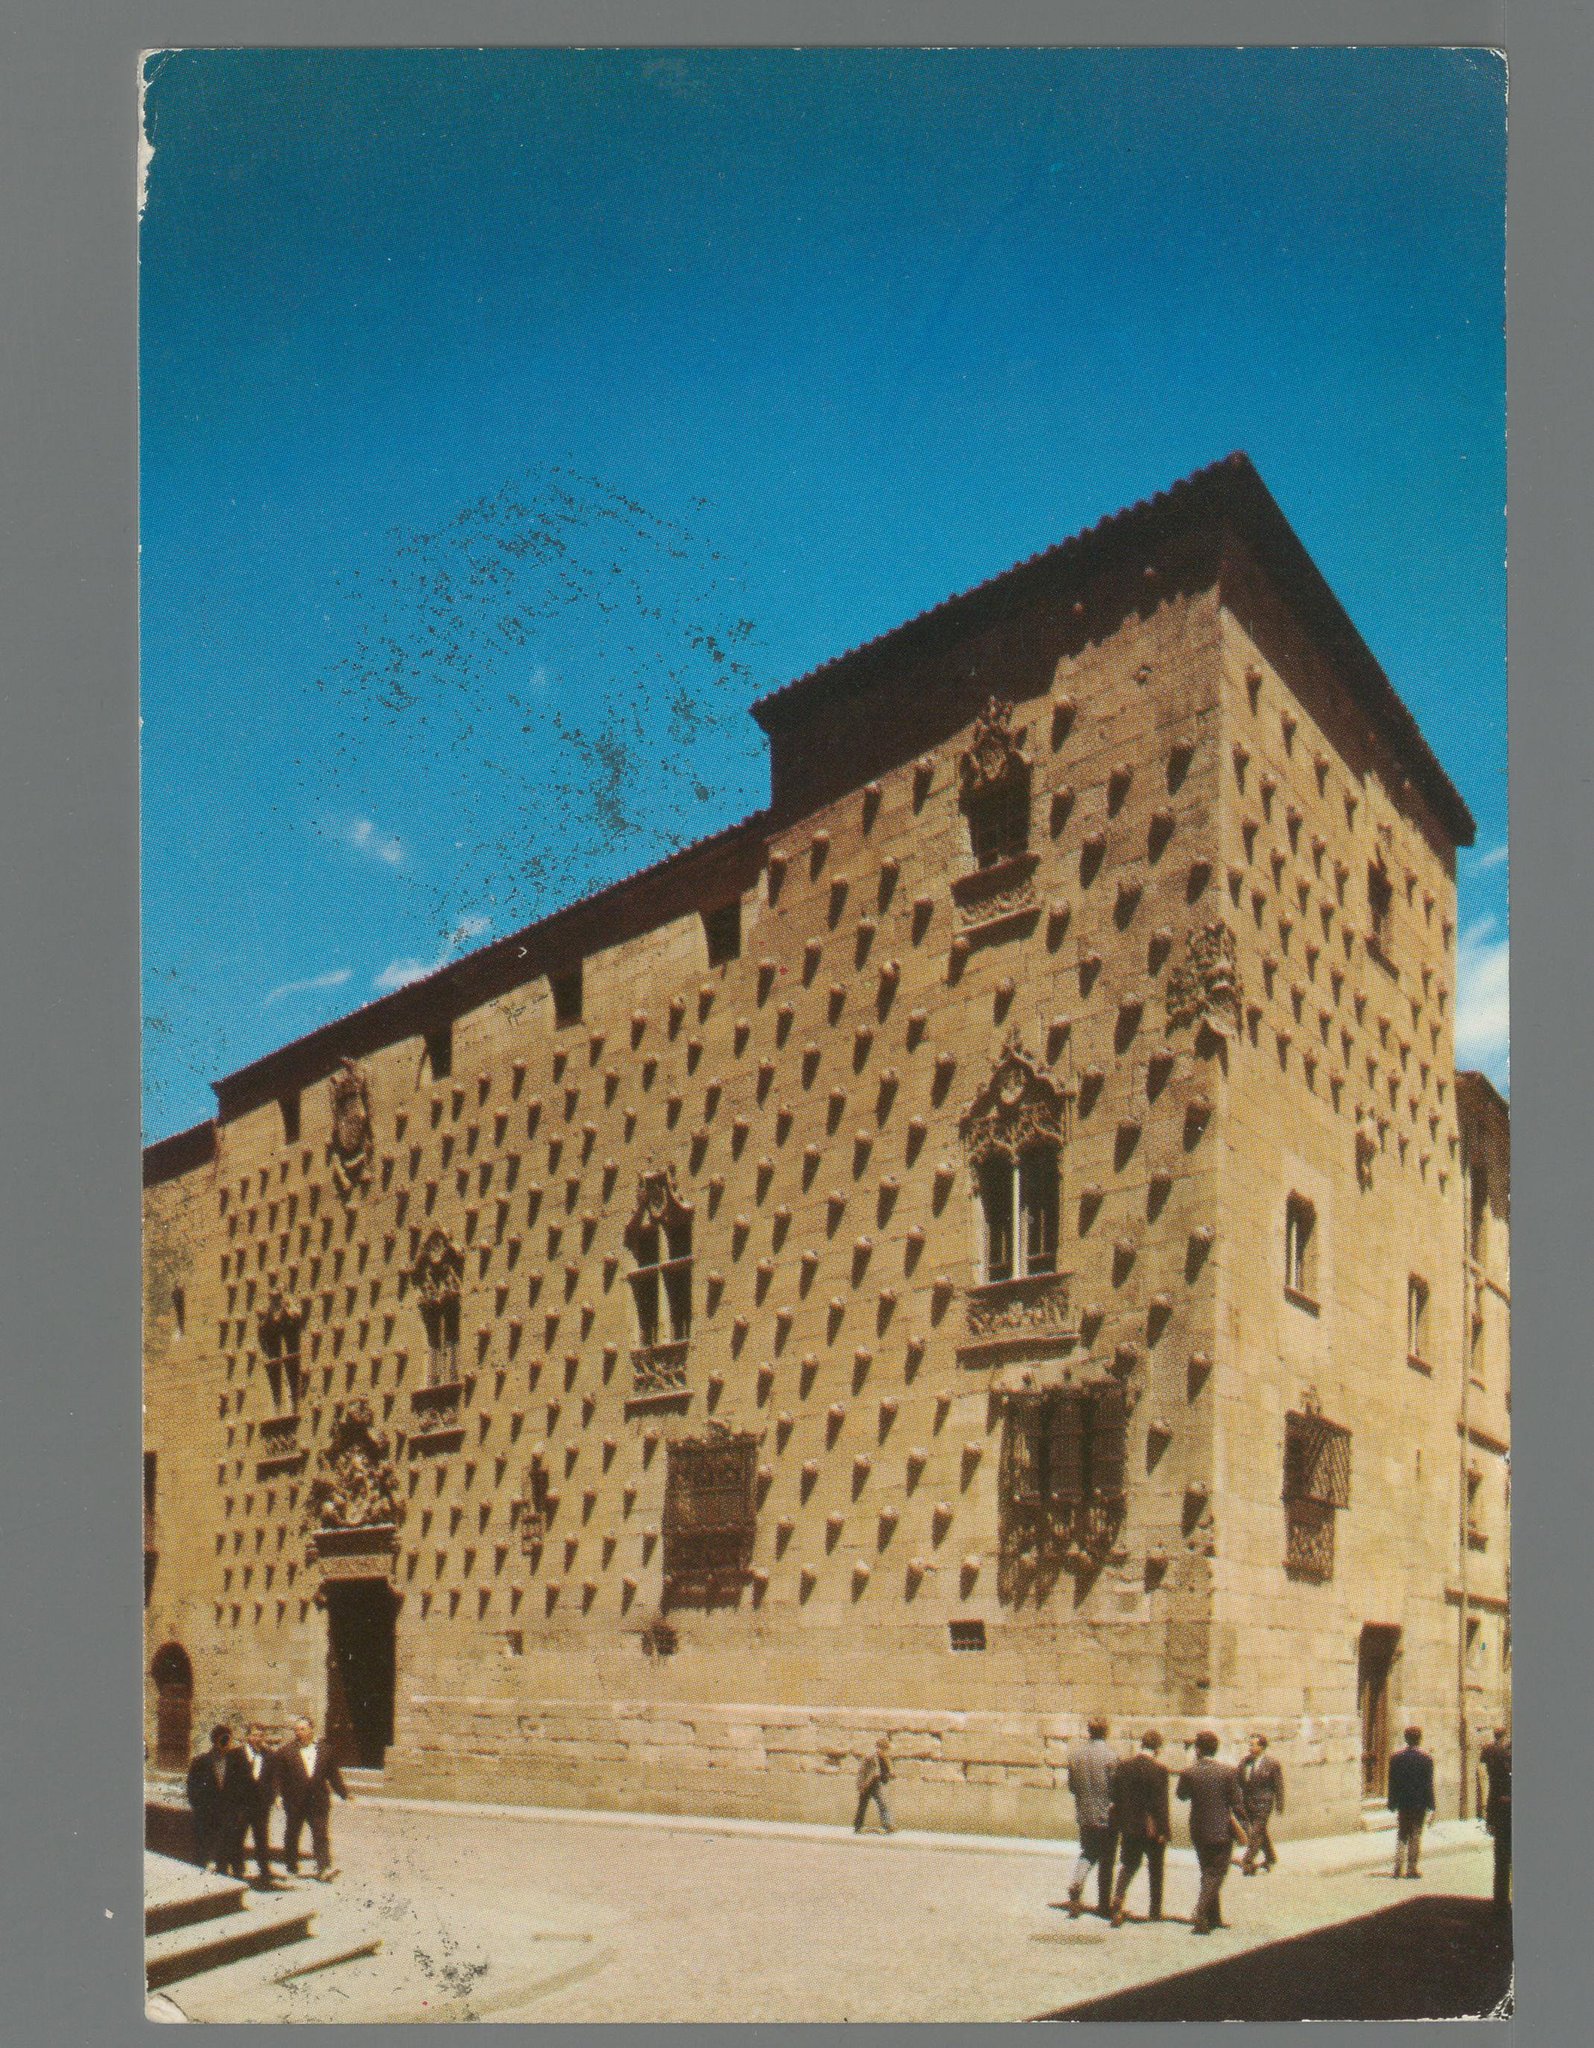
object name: photomechanical print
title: Salamanca. Casa de las conchas / La maison des conques / The house of shells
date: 1962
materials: cardboard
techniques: offset printed, writing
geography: vitoria-gasteiz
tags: scallop, shell ~ ornament, façade (of house or building)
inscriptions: poststempel, verso, gestempeld